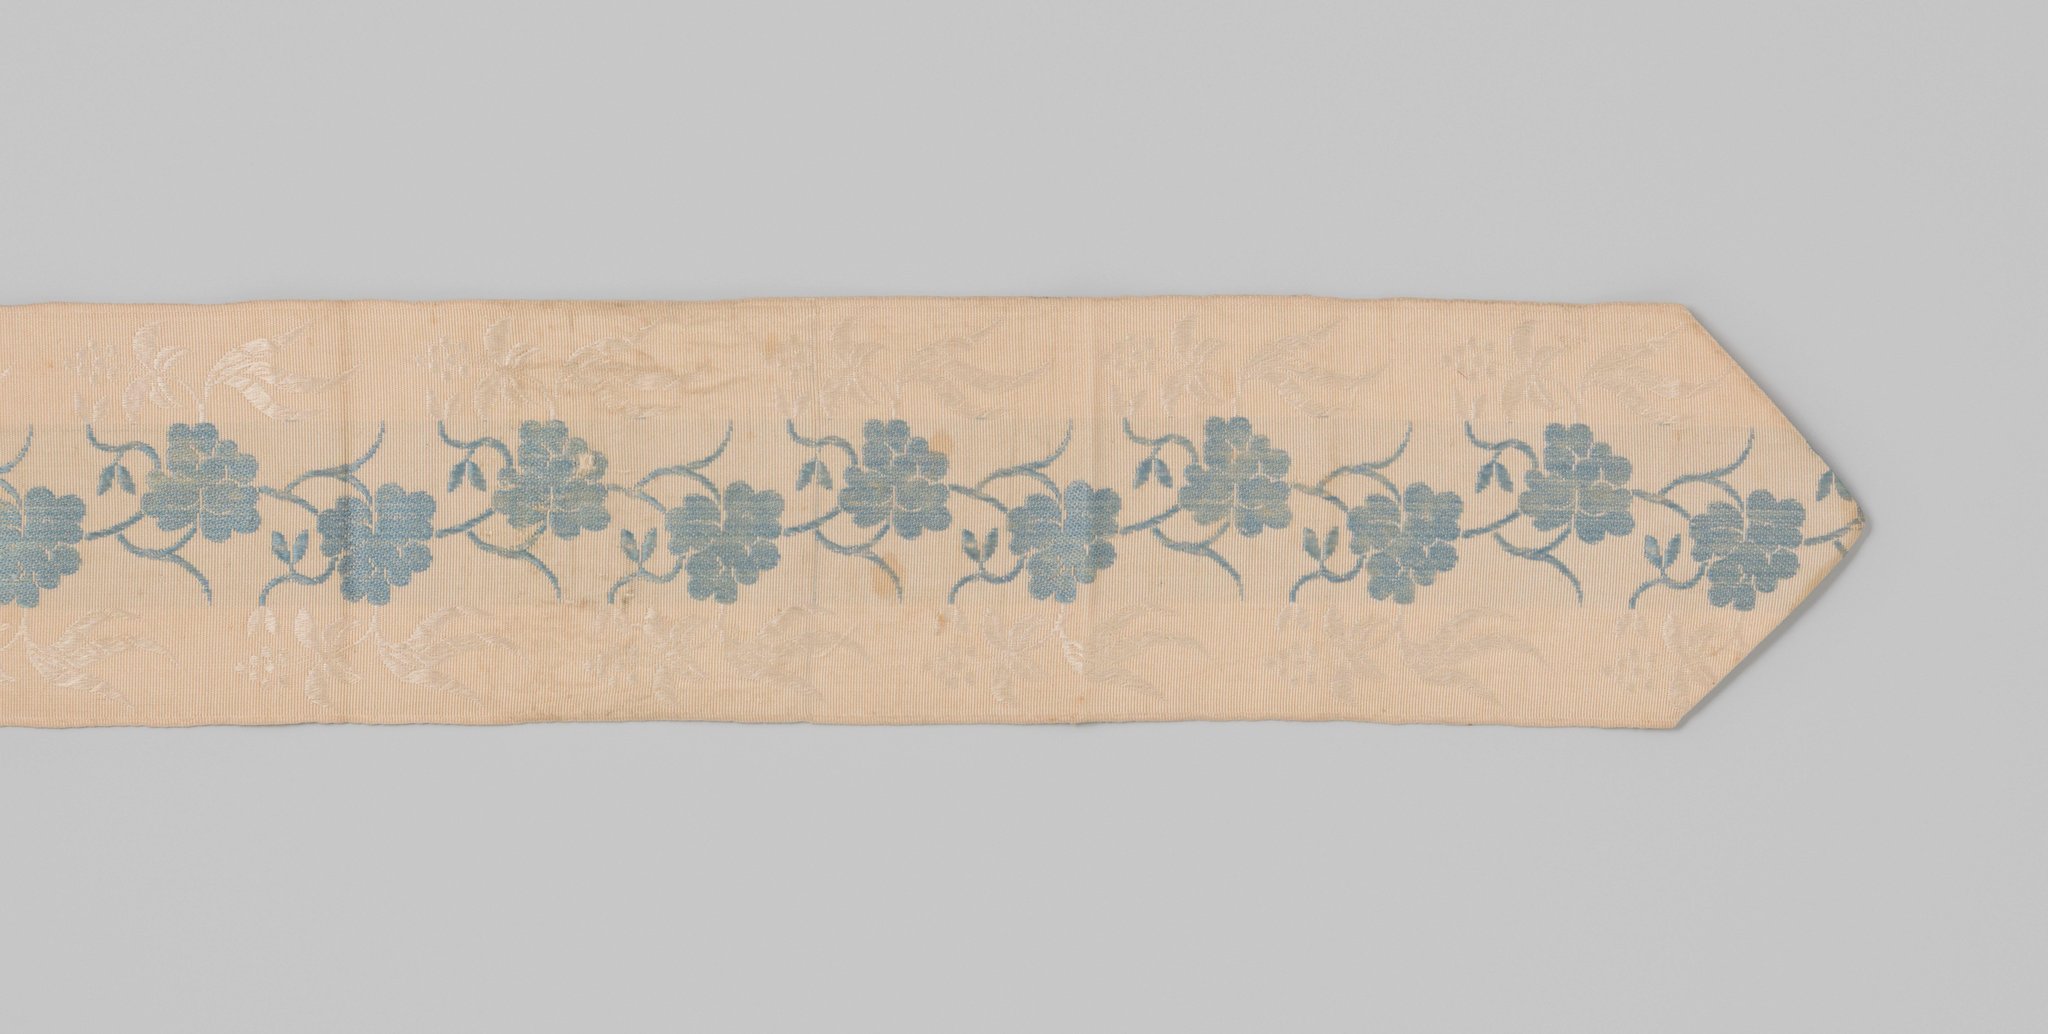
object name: ribbon material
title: Ceintuurlint van crèmekleurige zijde in ripsbinding, versierd met brocheerwerk; over het midden van het lint loopt een in blauw uitgevoerde bladrank, die aan beide kanten wordt geflankeerd door bessentakken in wit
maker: Anonymous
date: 1820-1830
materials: silk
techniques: brocade, weave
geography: netherlands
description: Ceintuurlint van crèmekleurige zijde in ripsbinding, versierd met brocheerwerk. Over het midden van het lint loopt een in blauw uitgevoerde bladrank, die aan beide kanten wordt geflankeerd door bessentakken in wit, waarschijnlijk dameskleding.